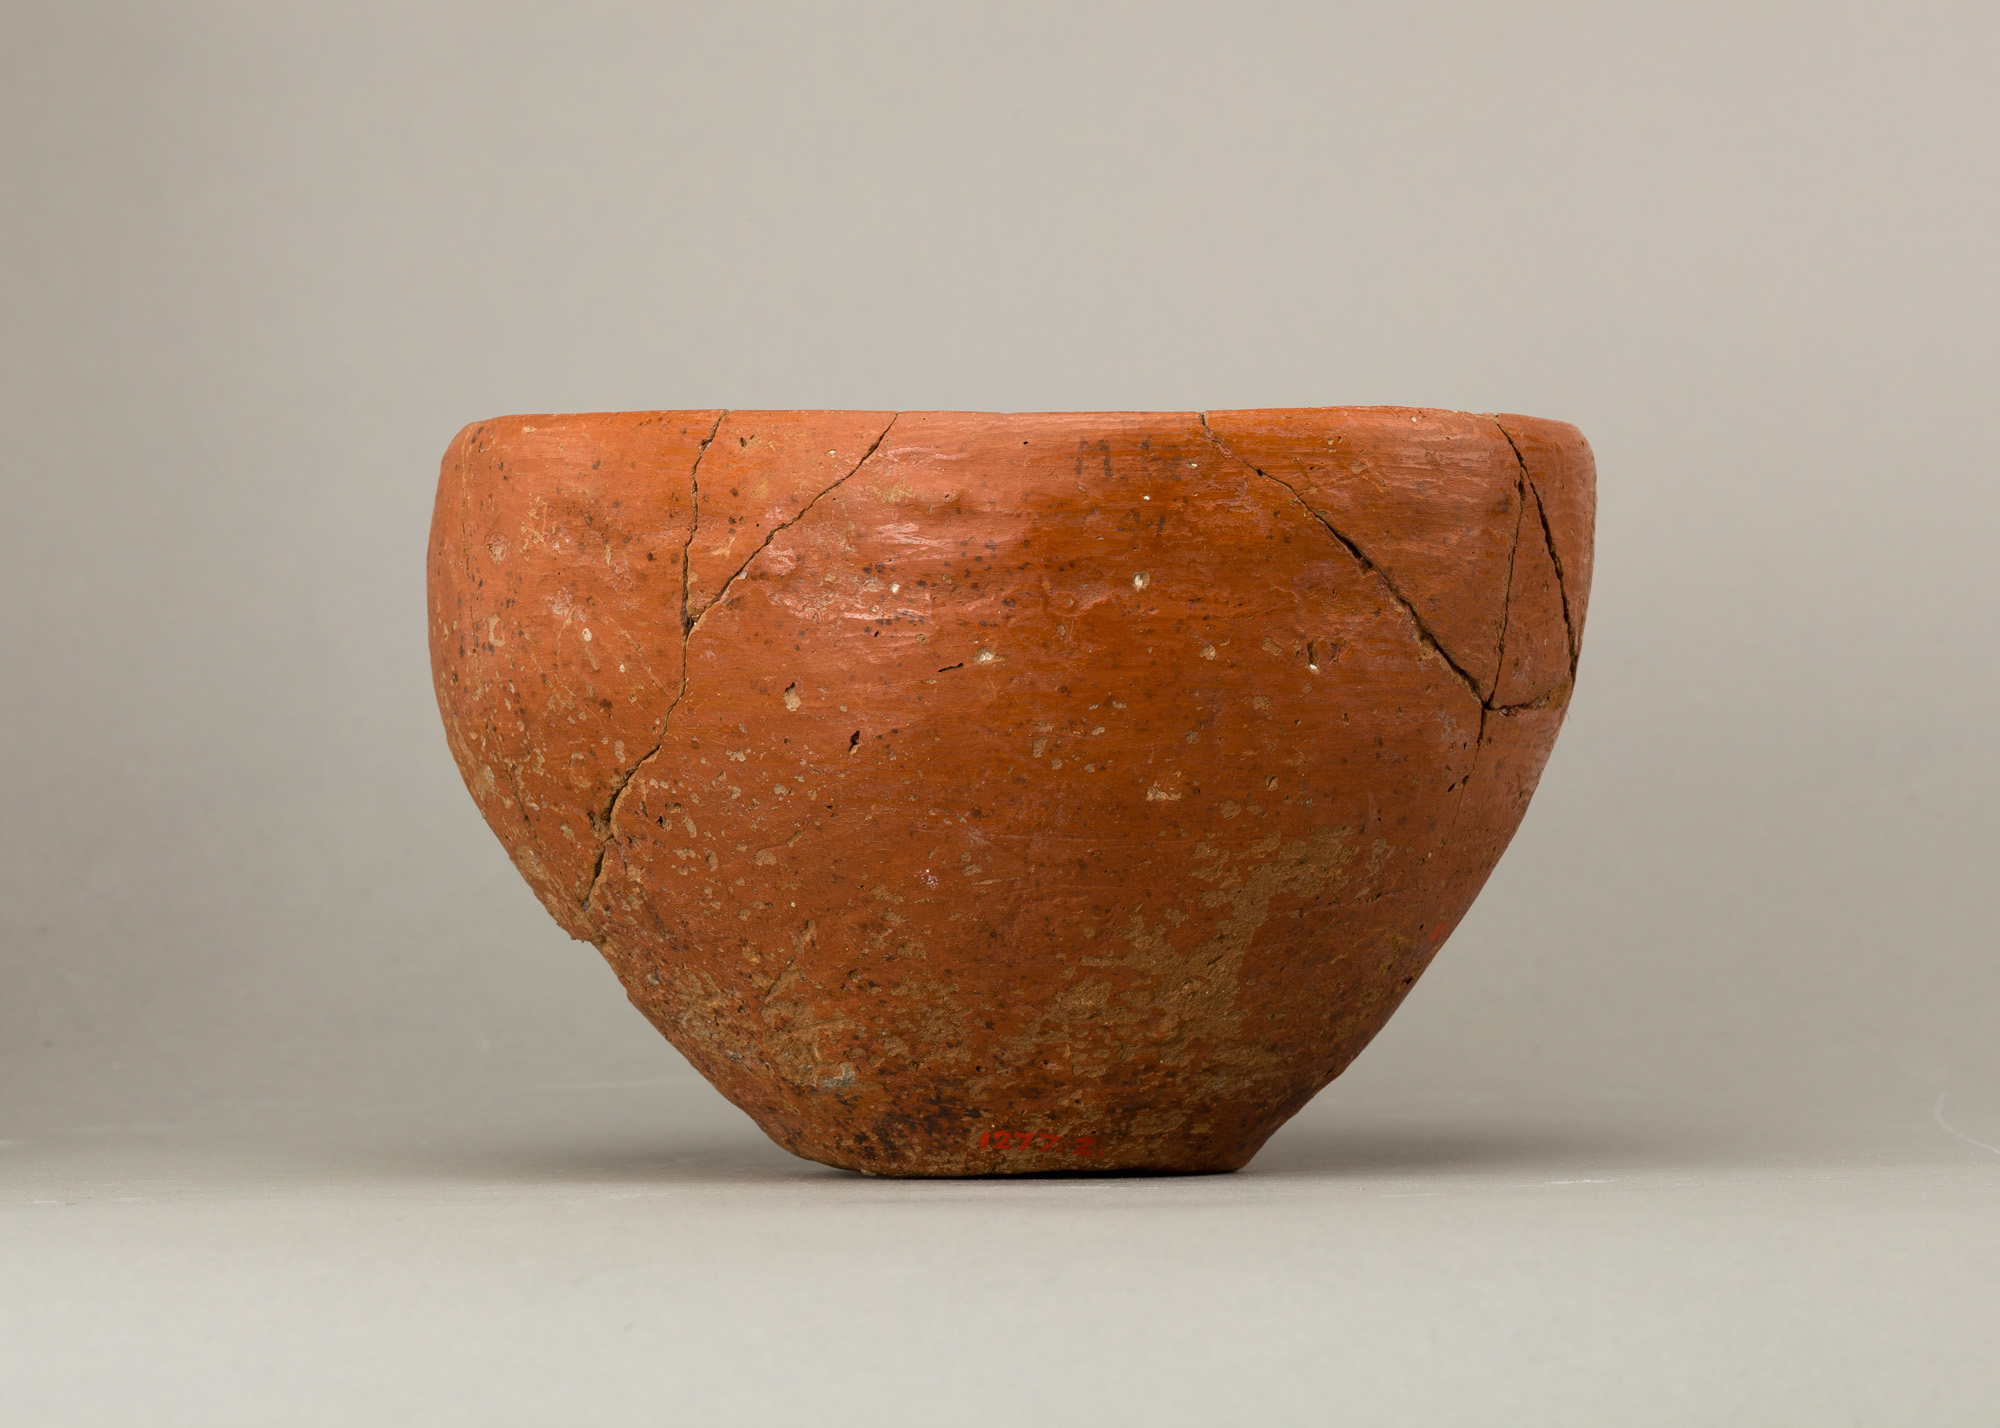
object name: bowl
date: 2960-2770 BCE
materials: pottery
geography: egypt